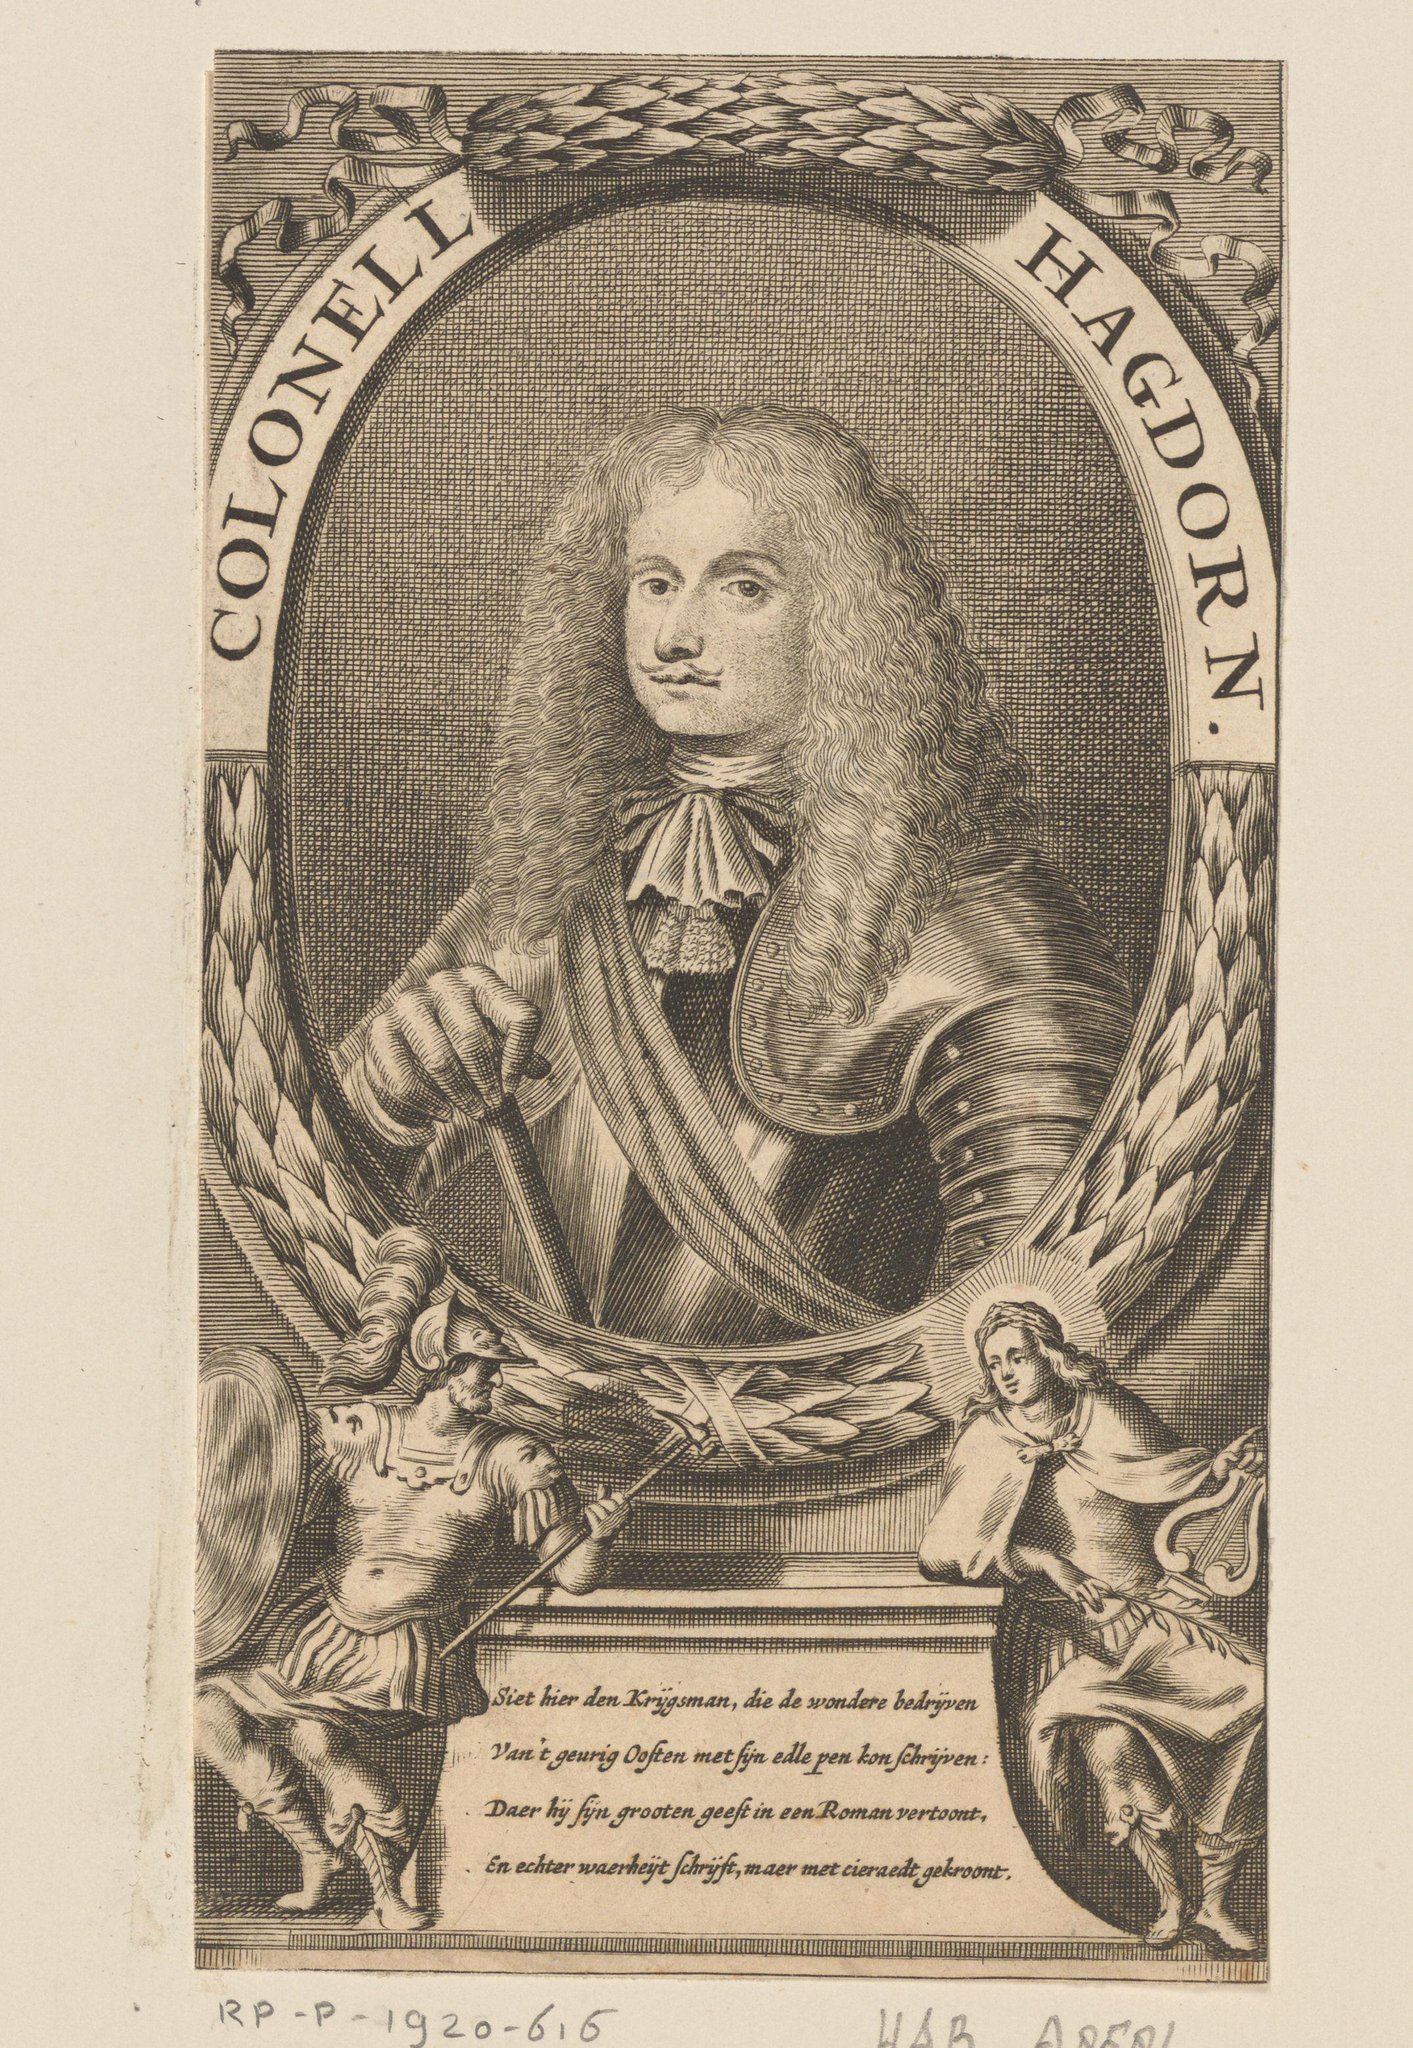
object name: print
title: Portret van Christian Wilhelm Hagdorn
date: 1671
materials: paper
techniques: engraving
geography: amsterdam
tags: armour, historical persons, writer, poet, author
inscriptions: collector's mark: Lugt 2228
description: Prent uit: Hagdorn, Christian Wilhelm. Eyquan, of Groote Mogol, (...). Amsterdam: Jacob van Meurs, 1671. Prent met Duits onderschrift gebruikt in de Duitse editie van dit werk, uitgegeven in 1670 bij dezelfde uitgever.